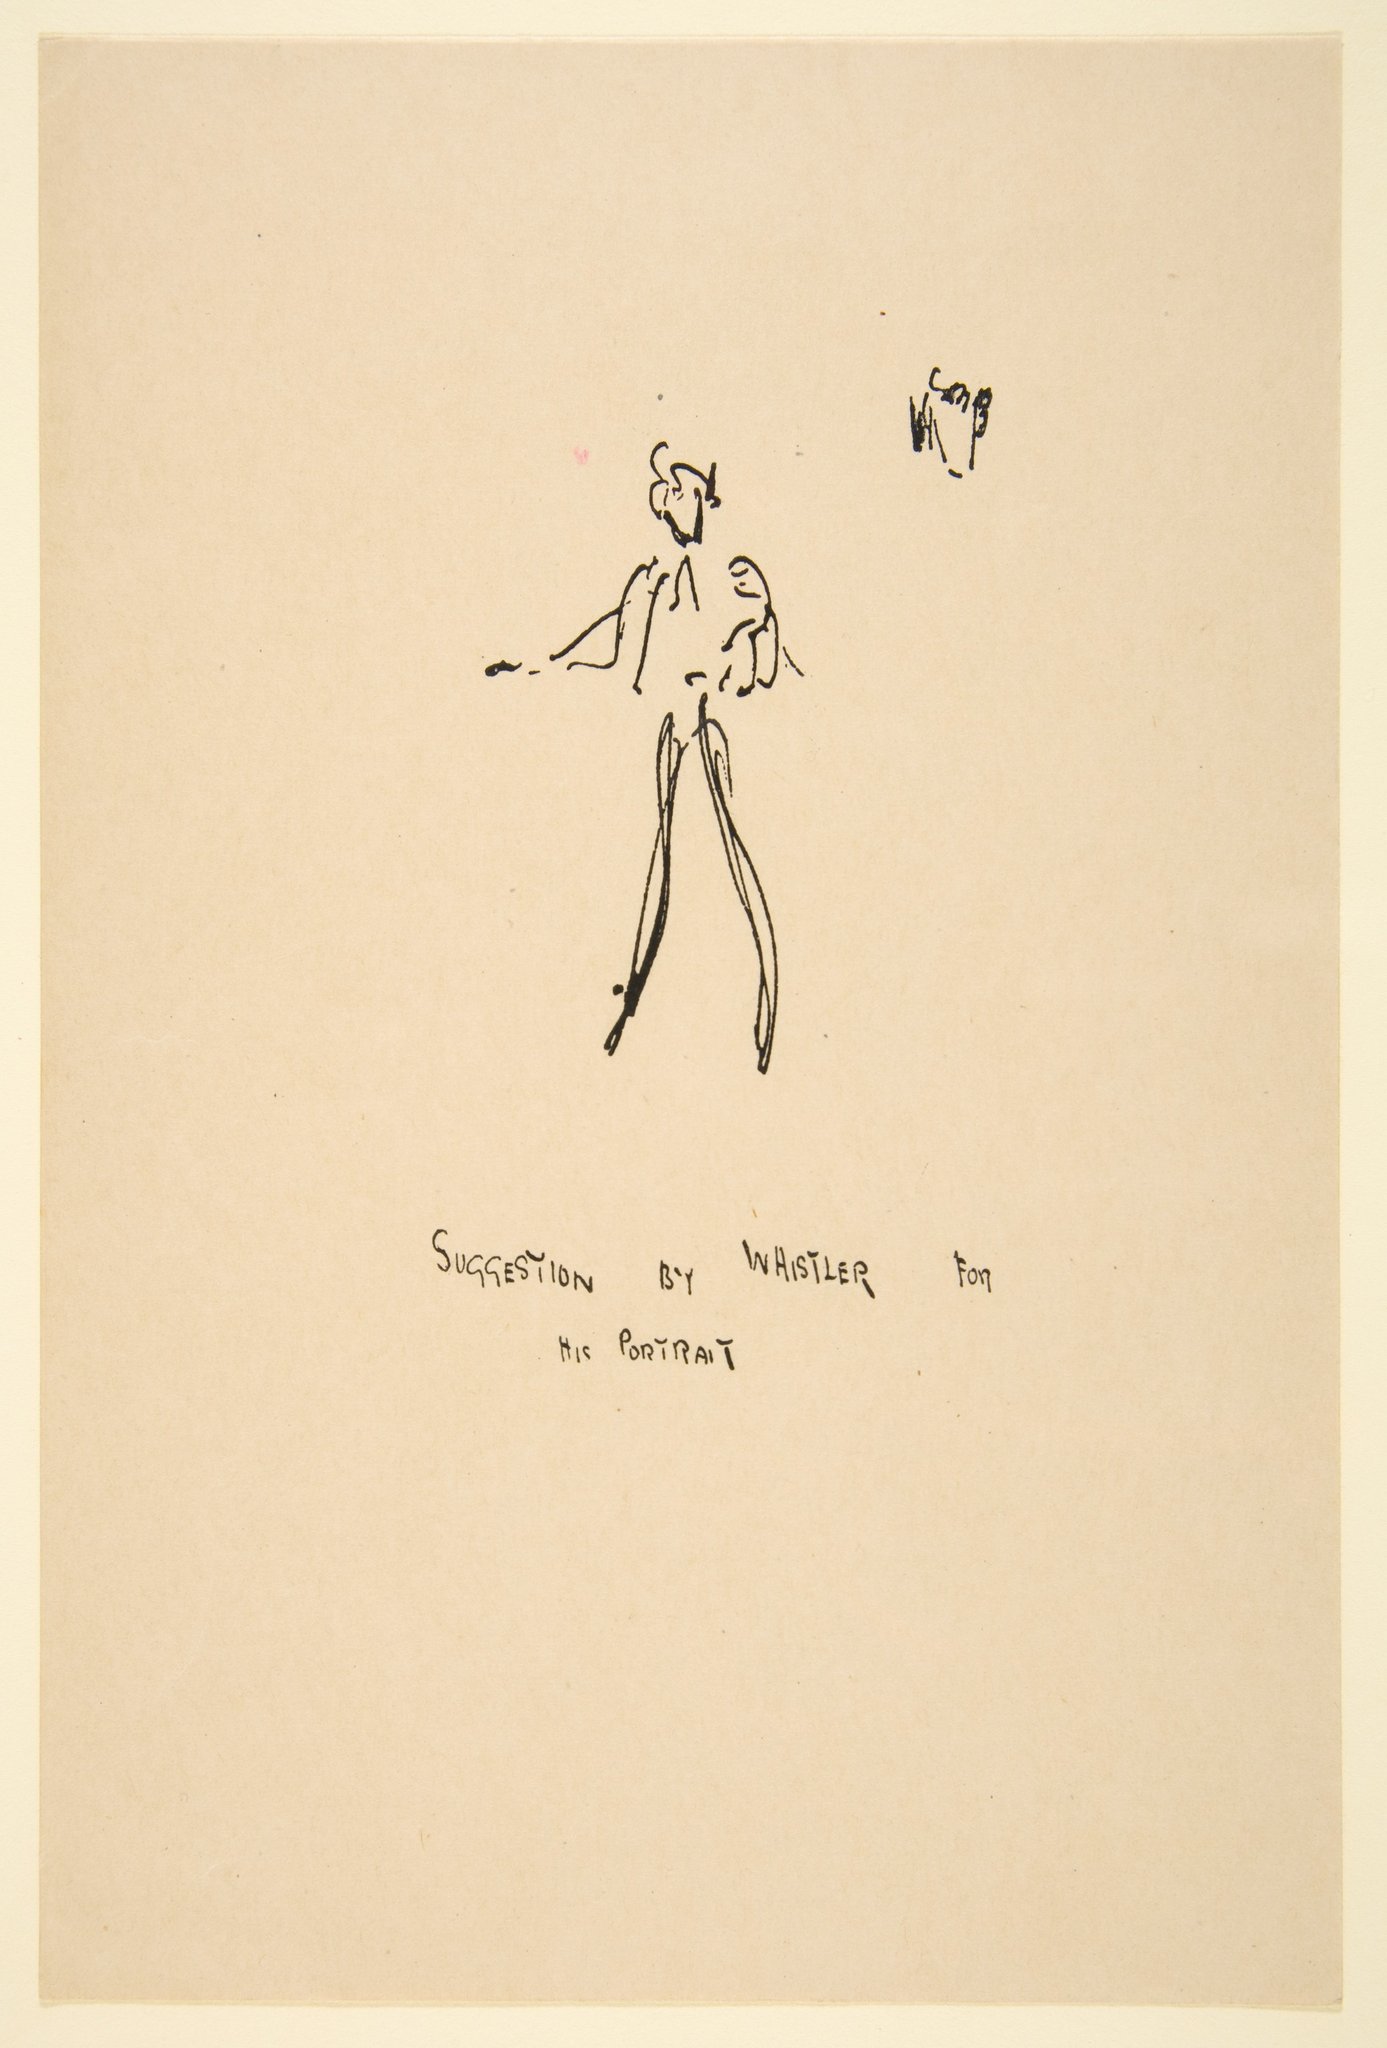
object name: print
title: Suggestion by Whistler for his Portrait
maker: james mcneill whistler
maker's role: artist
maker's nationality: american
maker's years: 1834-1903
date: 1801-2000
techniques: relief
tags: human figures